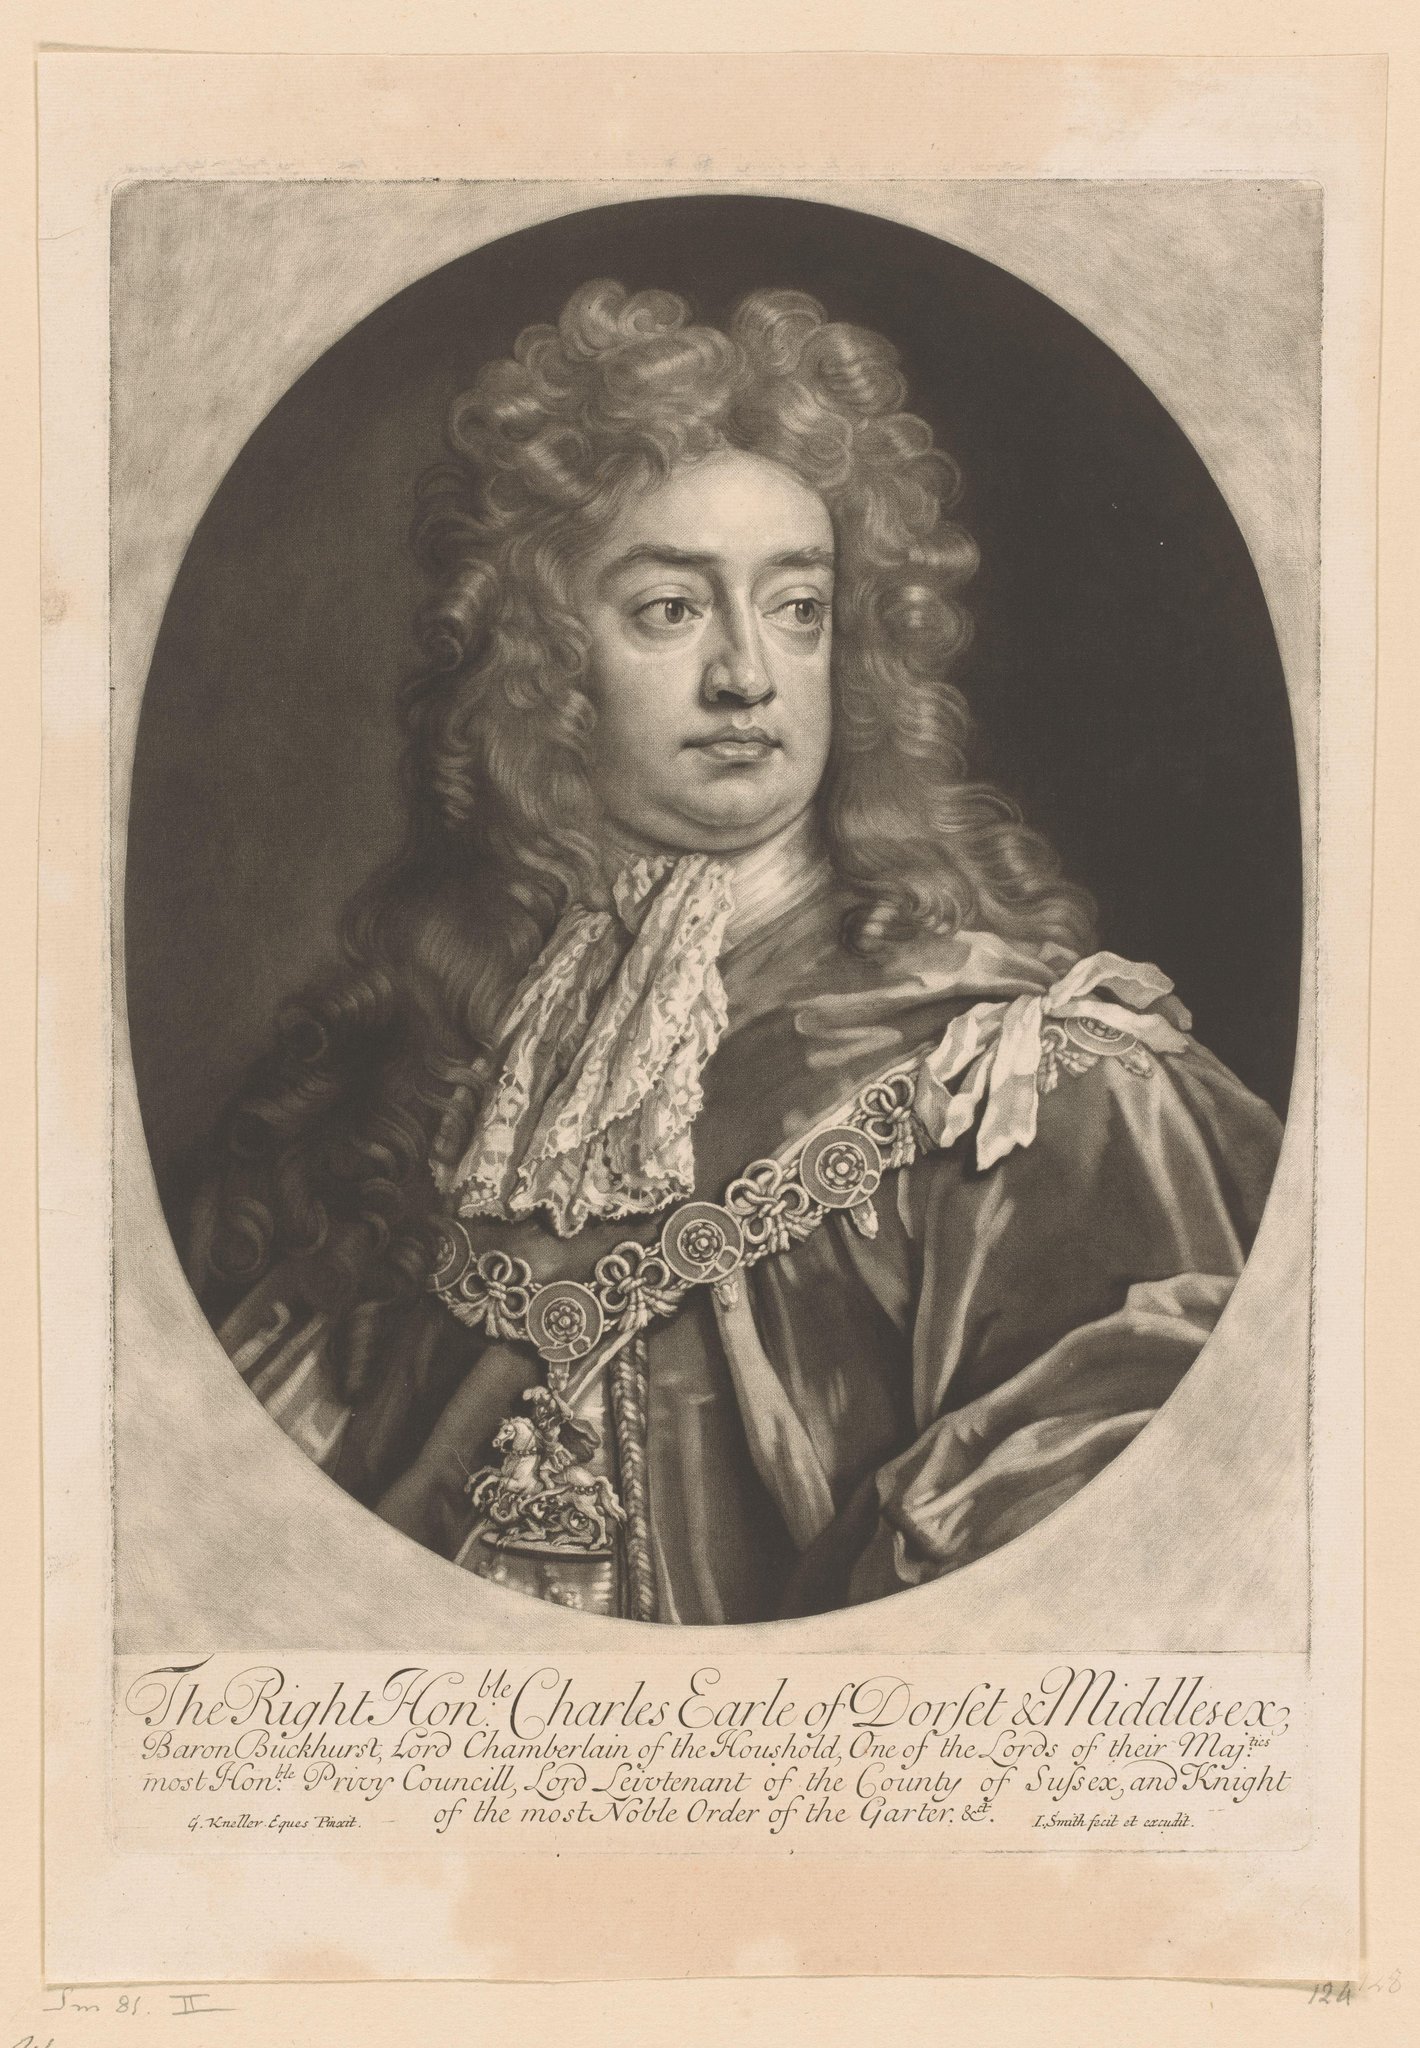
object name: print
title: The Right Honorable Charles Earle of Dorse & Middlesex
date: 1662-1742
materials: paper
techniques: mezzotint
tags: earl, historical persons, politician, e.g. party leader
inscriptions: collector's mark: Lugt 240